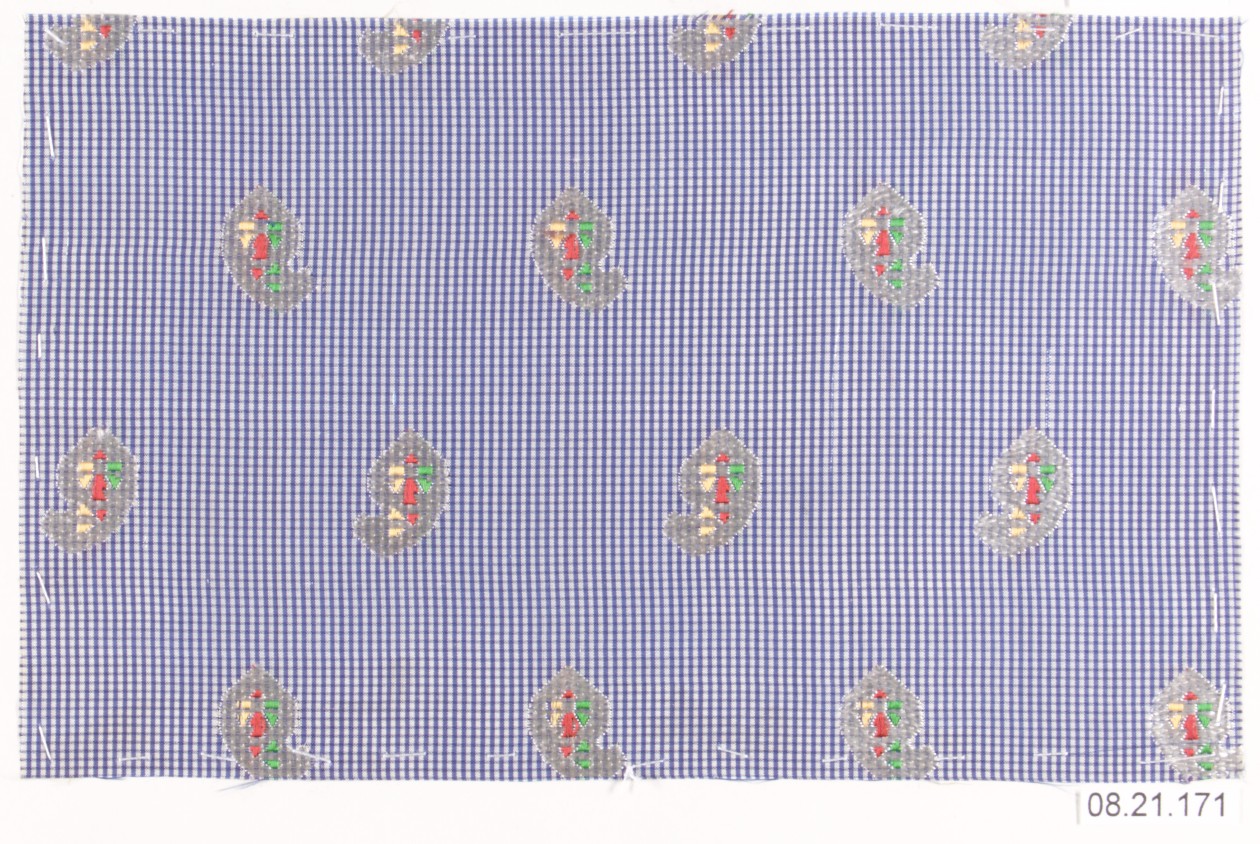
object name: textile sample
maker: Anonymous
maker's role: designer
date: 1900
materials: silk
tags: flowers